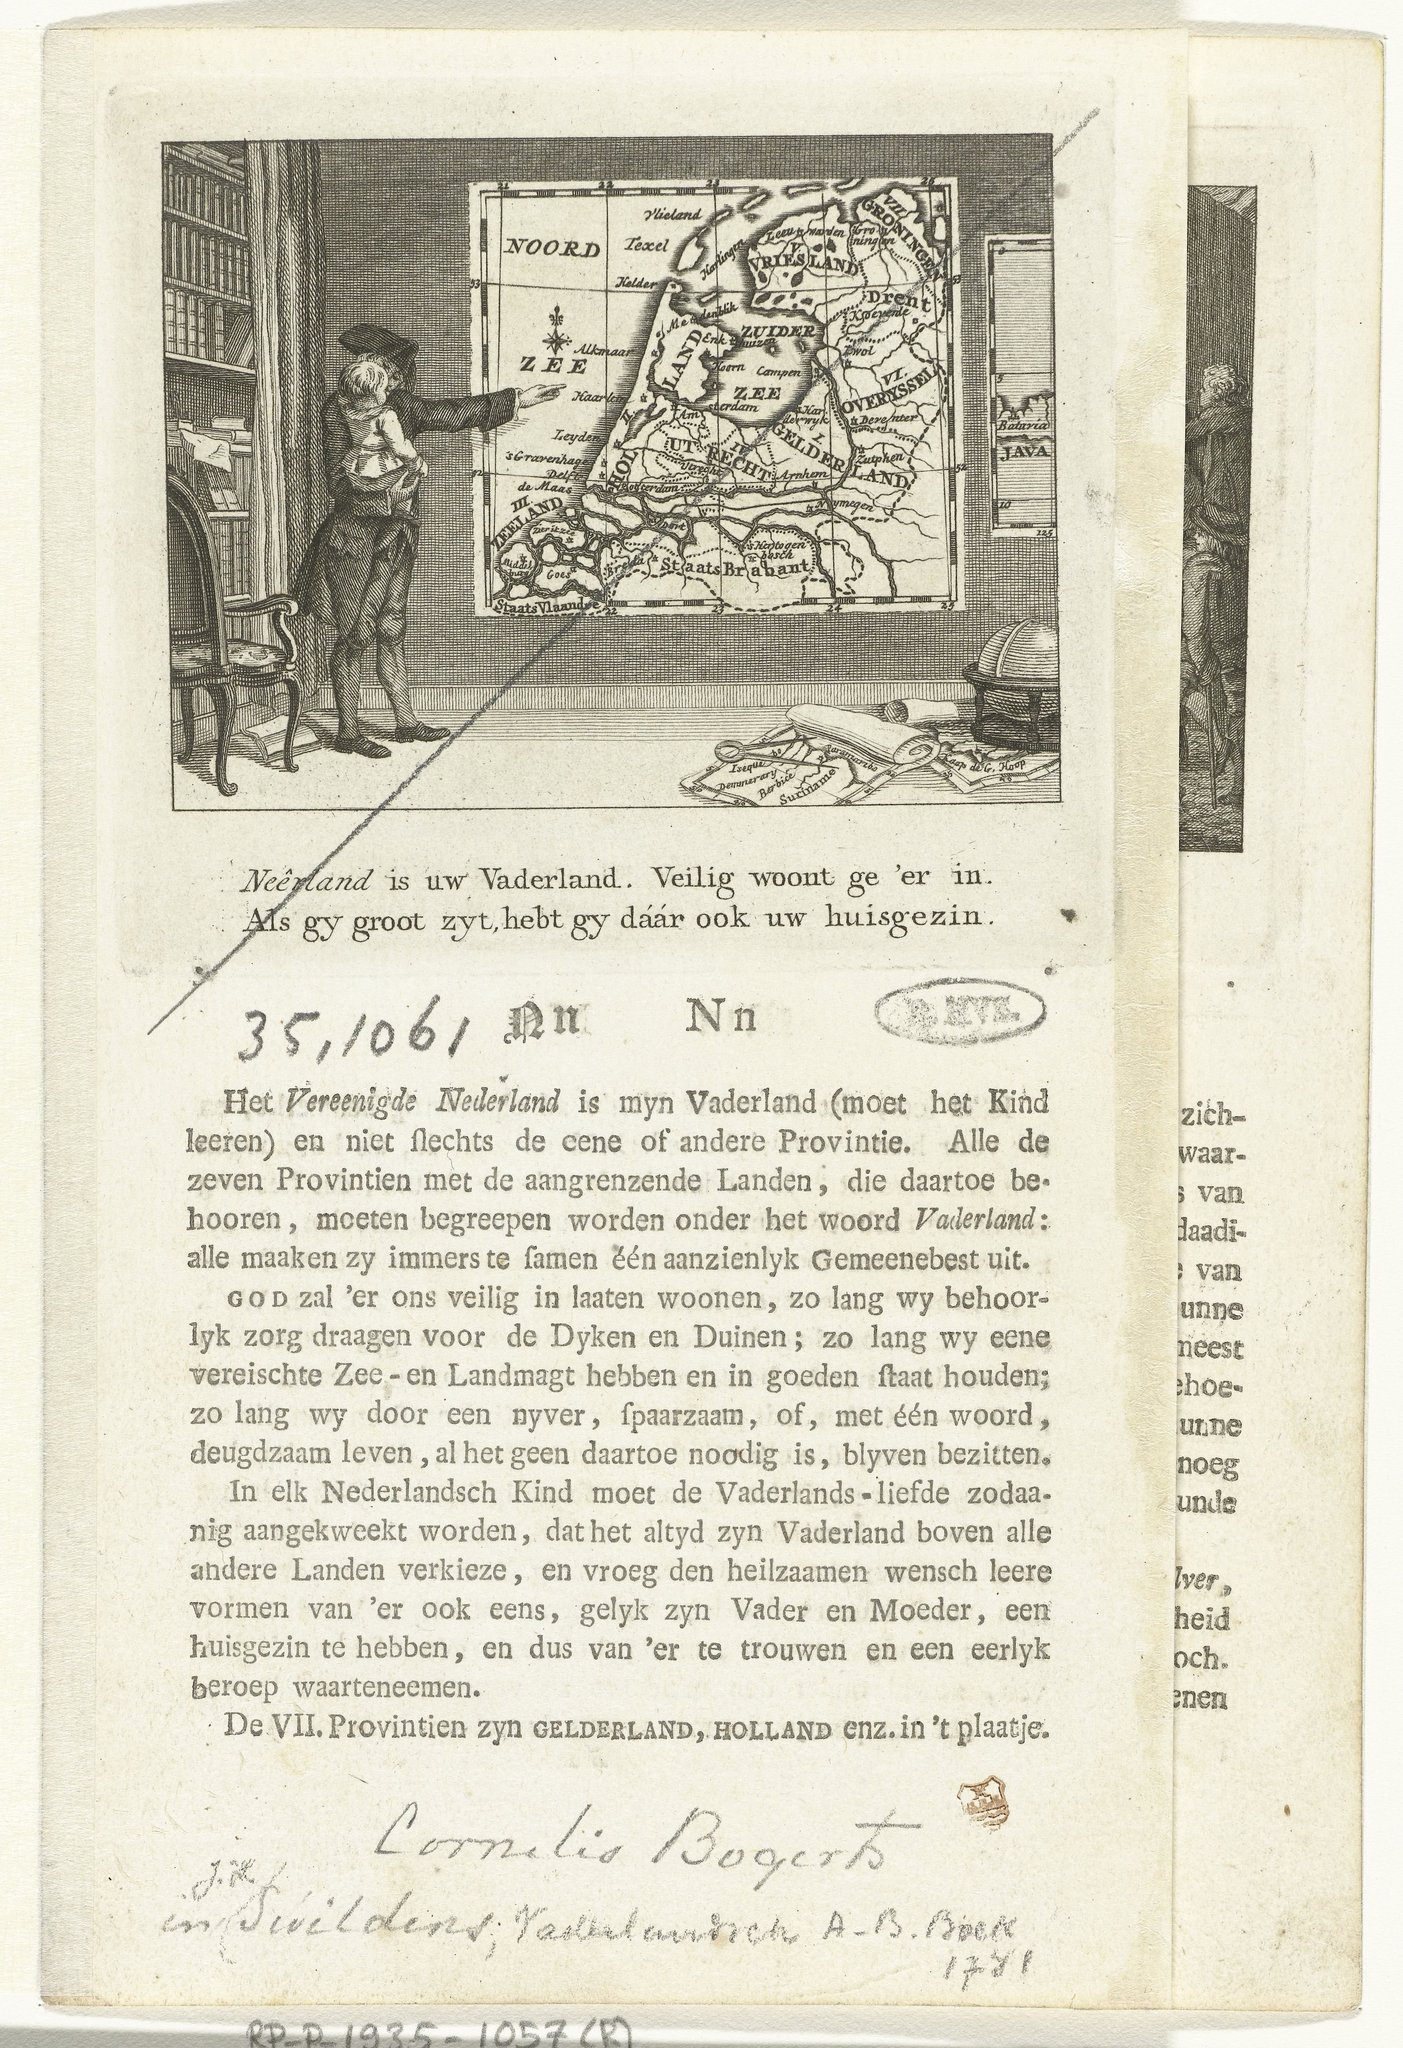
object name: print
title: Een vader toont zijn kind Nederland op een landkaart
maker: cornelis bogerts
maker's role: print maker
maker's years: 1745-1817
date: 1781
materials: paper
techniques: etching, letterpress printing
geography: amsterdam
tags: scholastic education, tuition (+ lesson, lecture), studying a map, netherlands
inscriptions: collector's mark: Lugt 2760, collector's mark: Lugt 2228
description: Letter N uit het Vaderlandsch A-B boek van J.H. Swildens. Een vader toont zijn kind de Verenigde Nederlanden op een landkaart. Onder de voorstelling een vers en een tekst over het belang van de vaderlandsliefde.